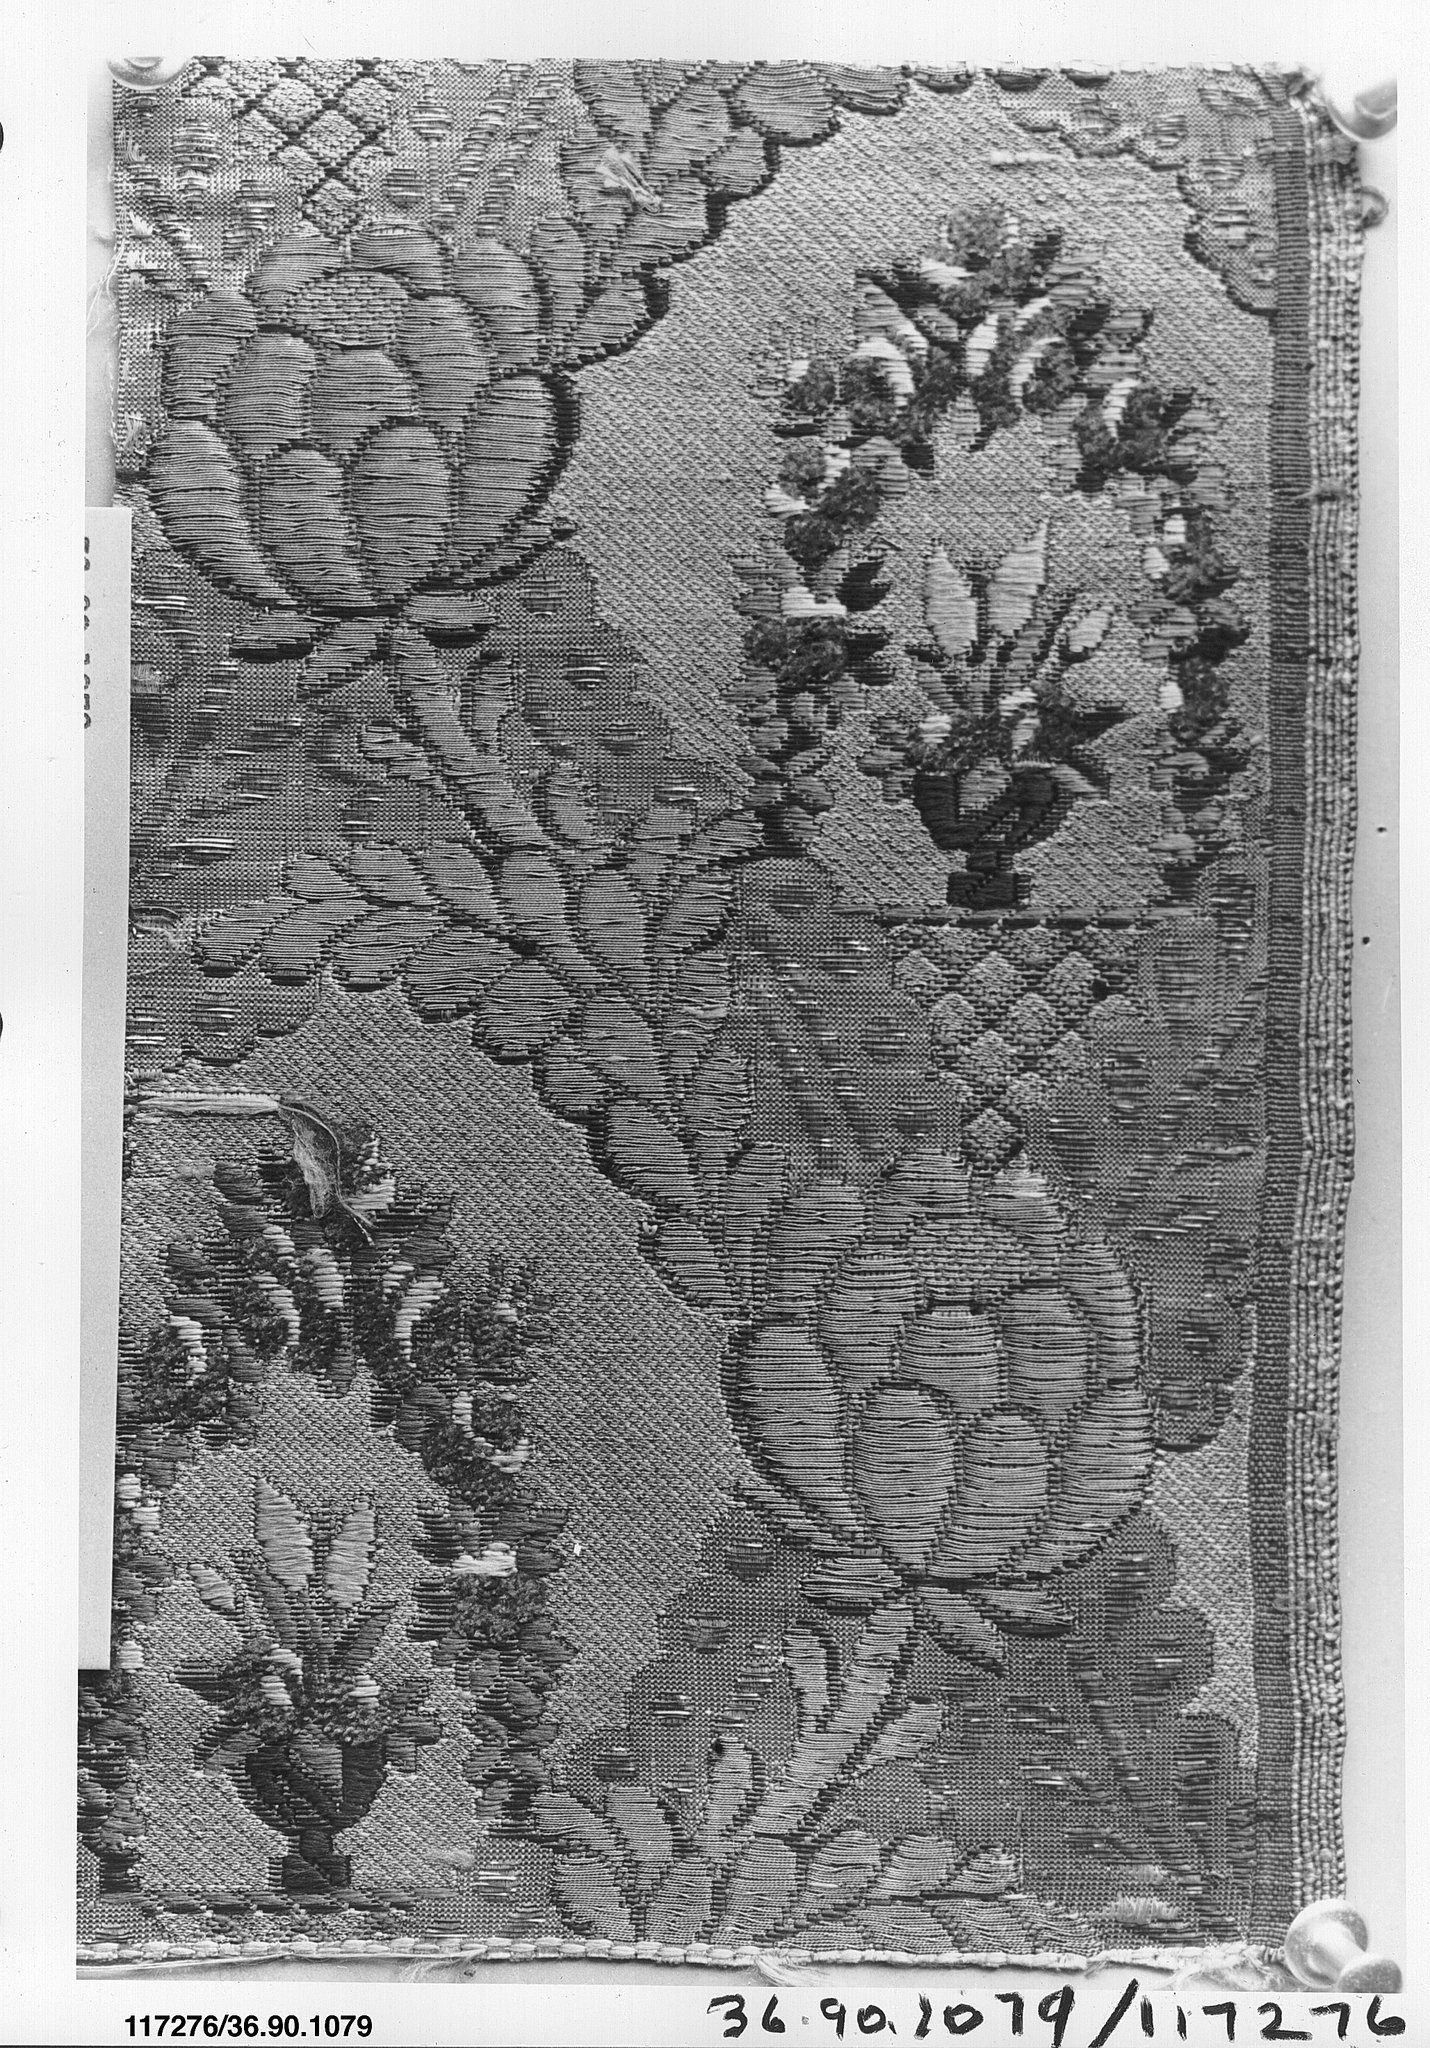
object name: piece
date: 1701-1900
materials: metal thread, silk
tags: flowers